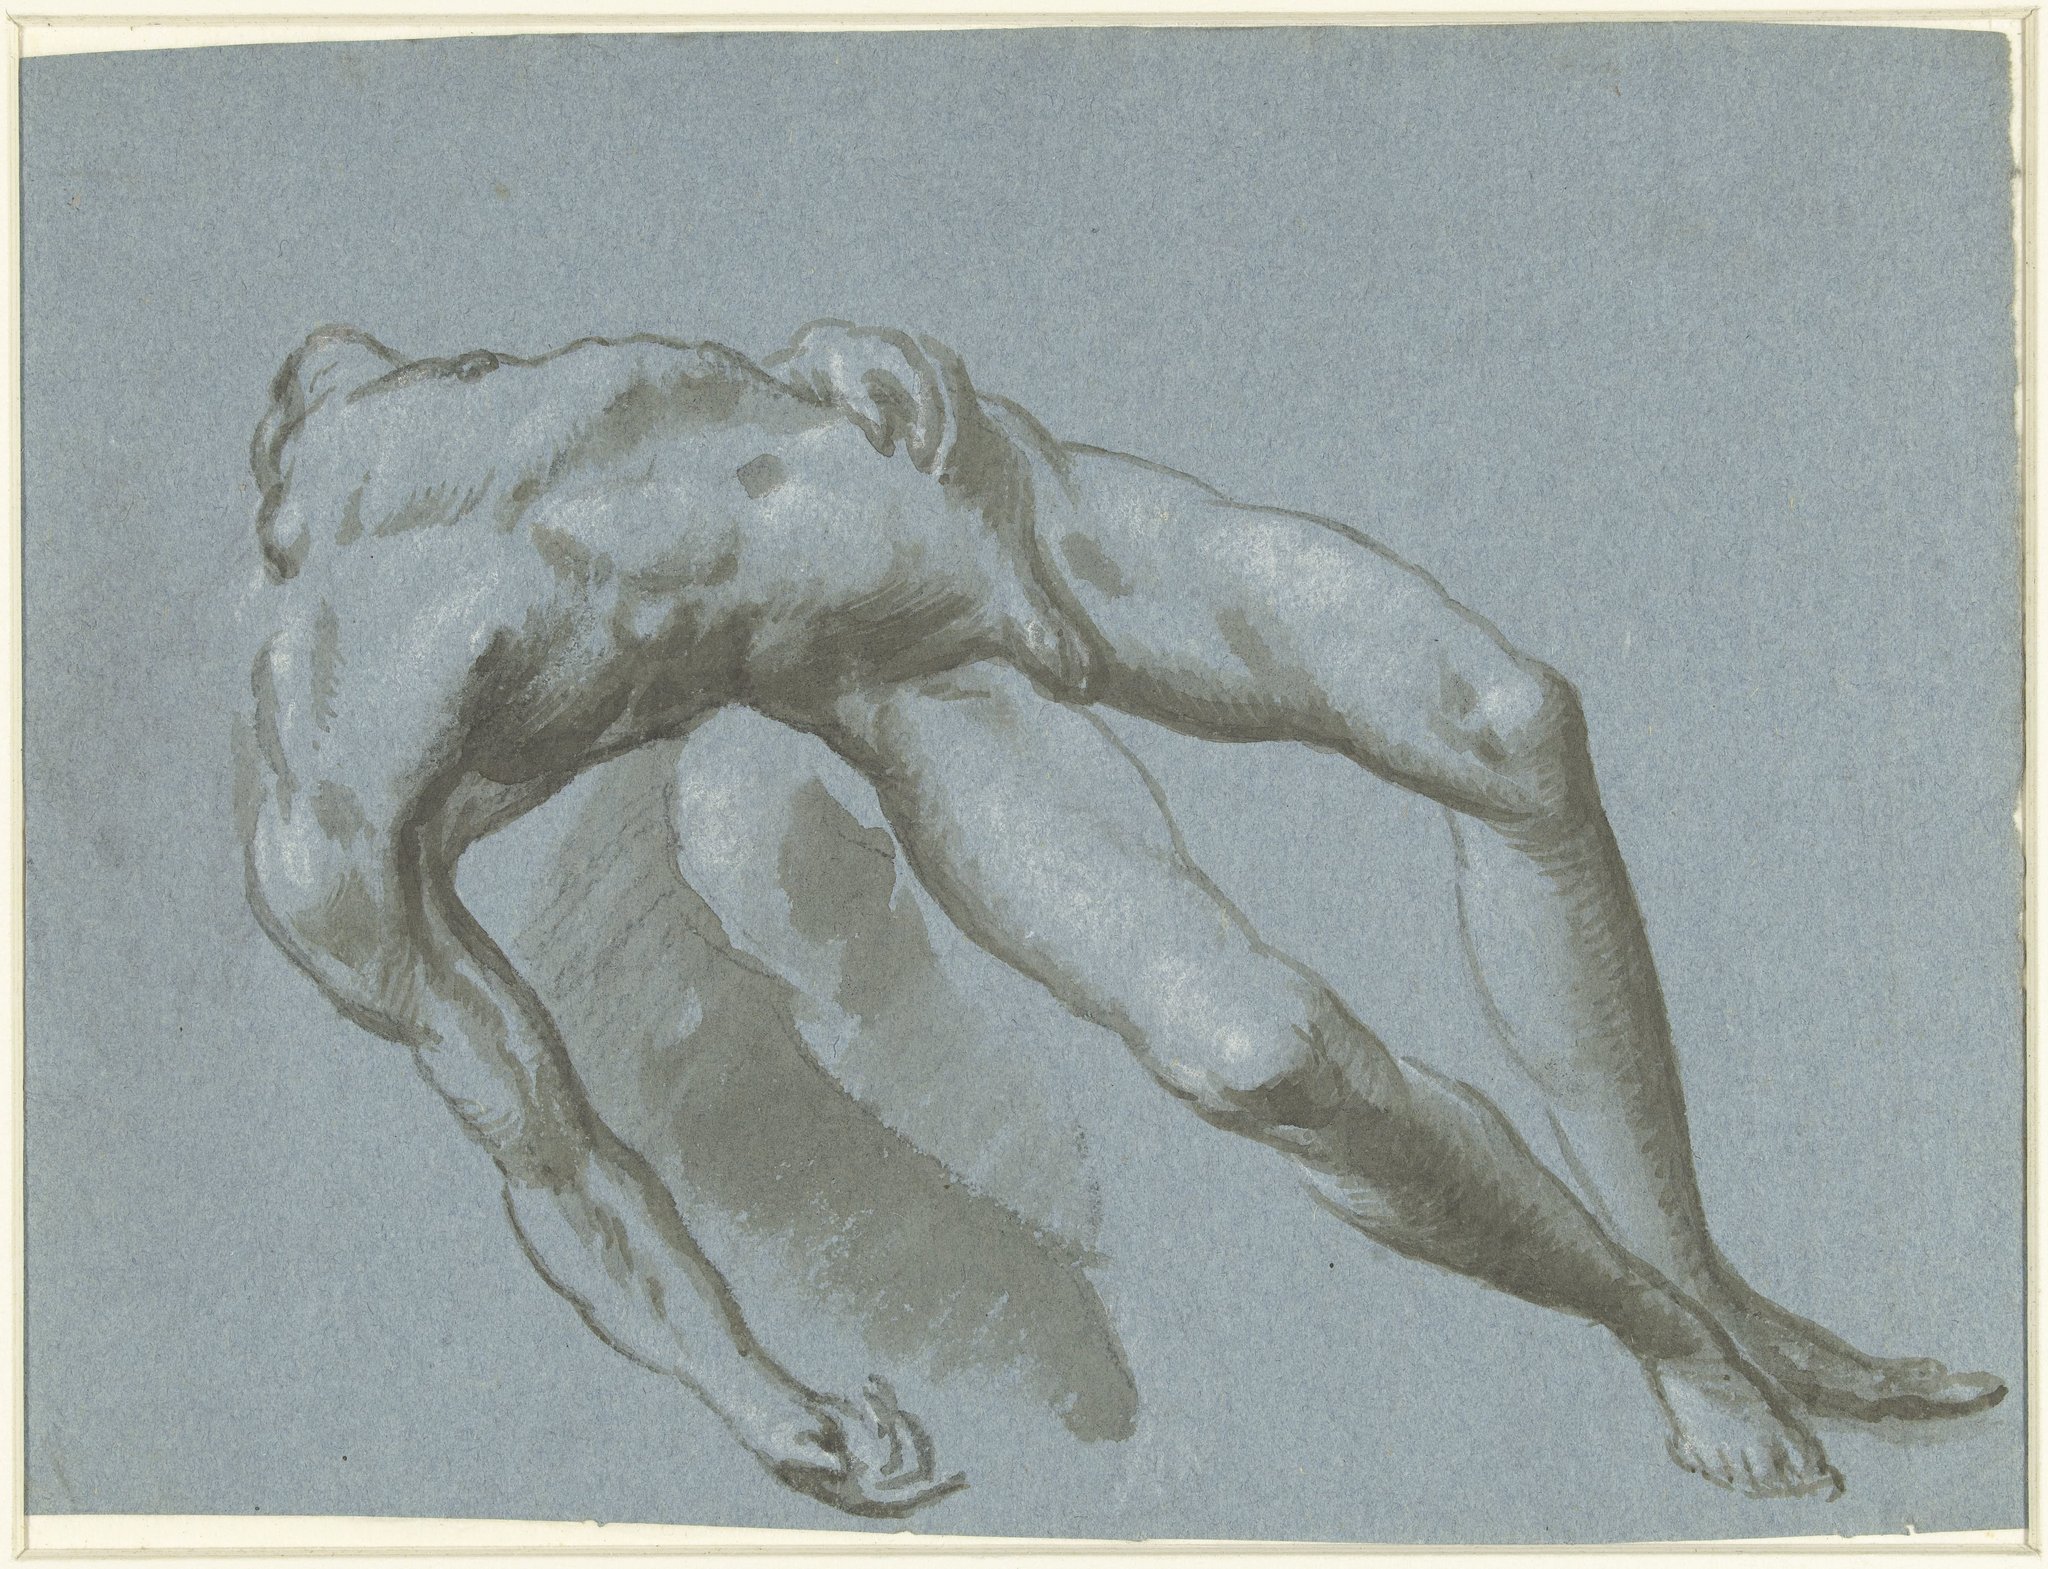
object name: drawing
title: Het lichaam van Christus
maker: Anonymous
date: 1610-1630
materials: paint, paper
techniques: brush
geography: verona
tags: christ's body lying on the ground, christ's body supported, lying figure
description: Het lichaam van Christus, uit een bewening.